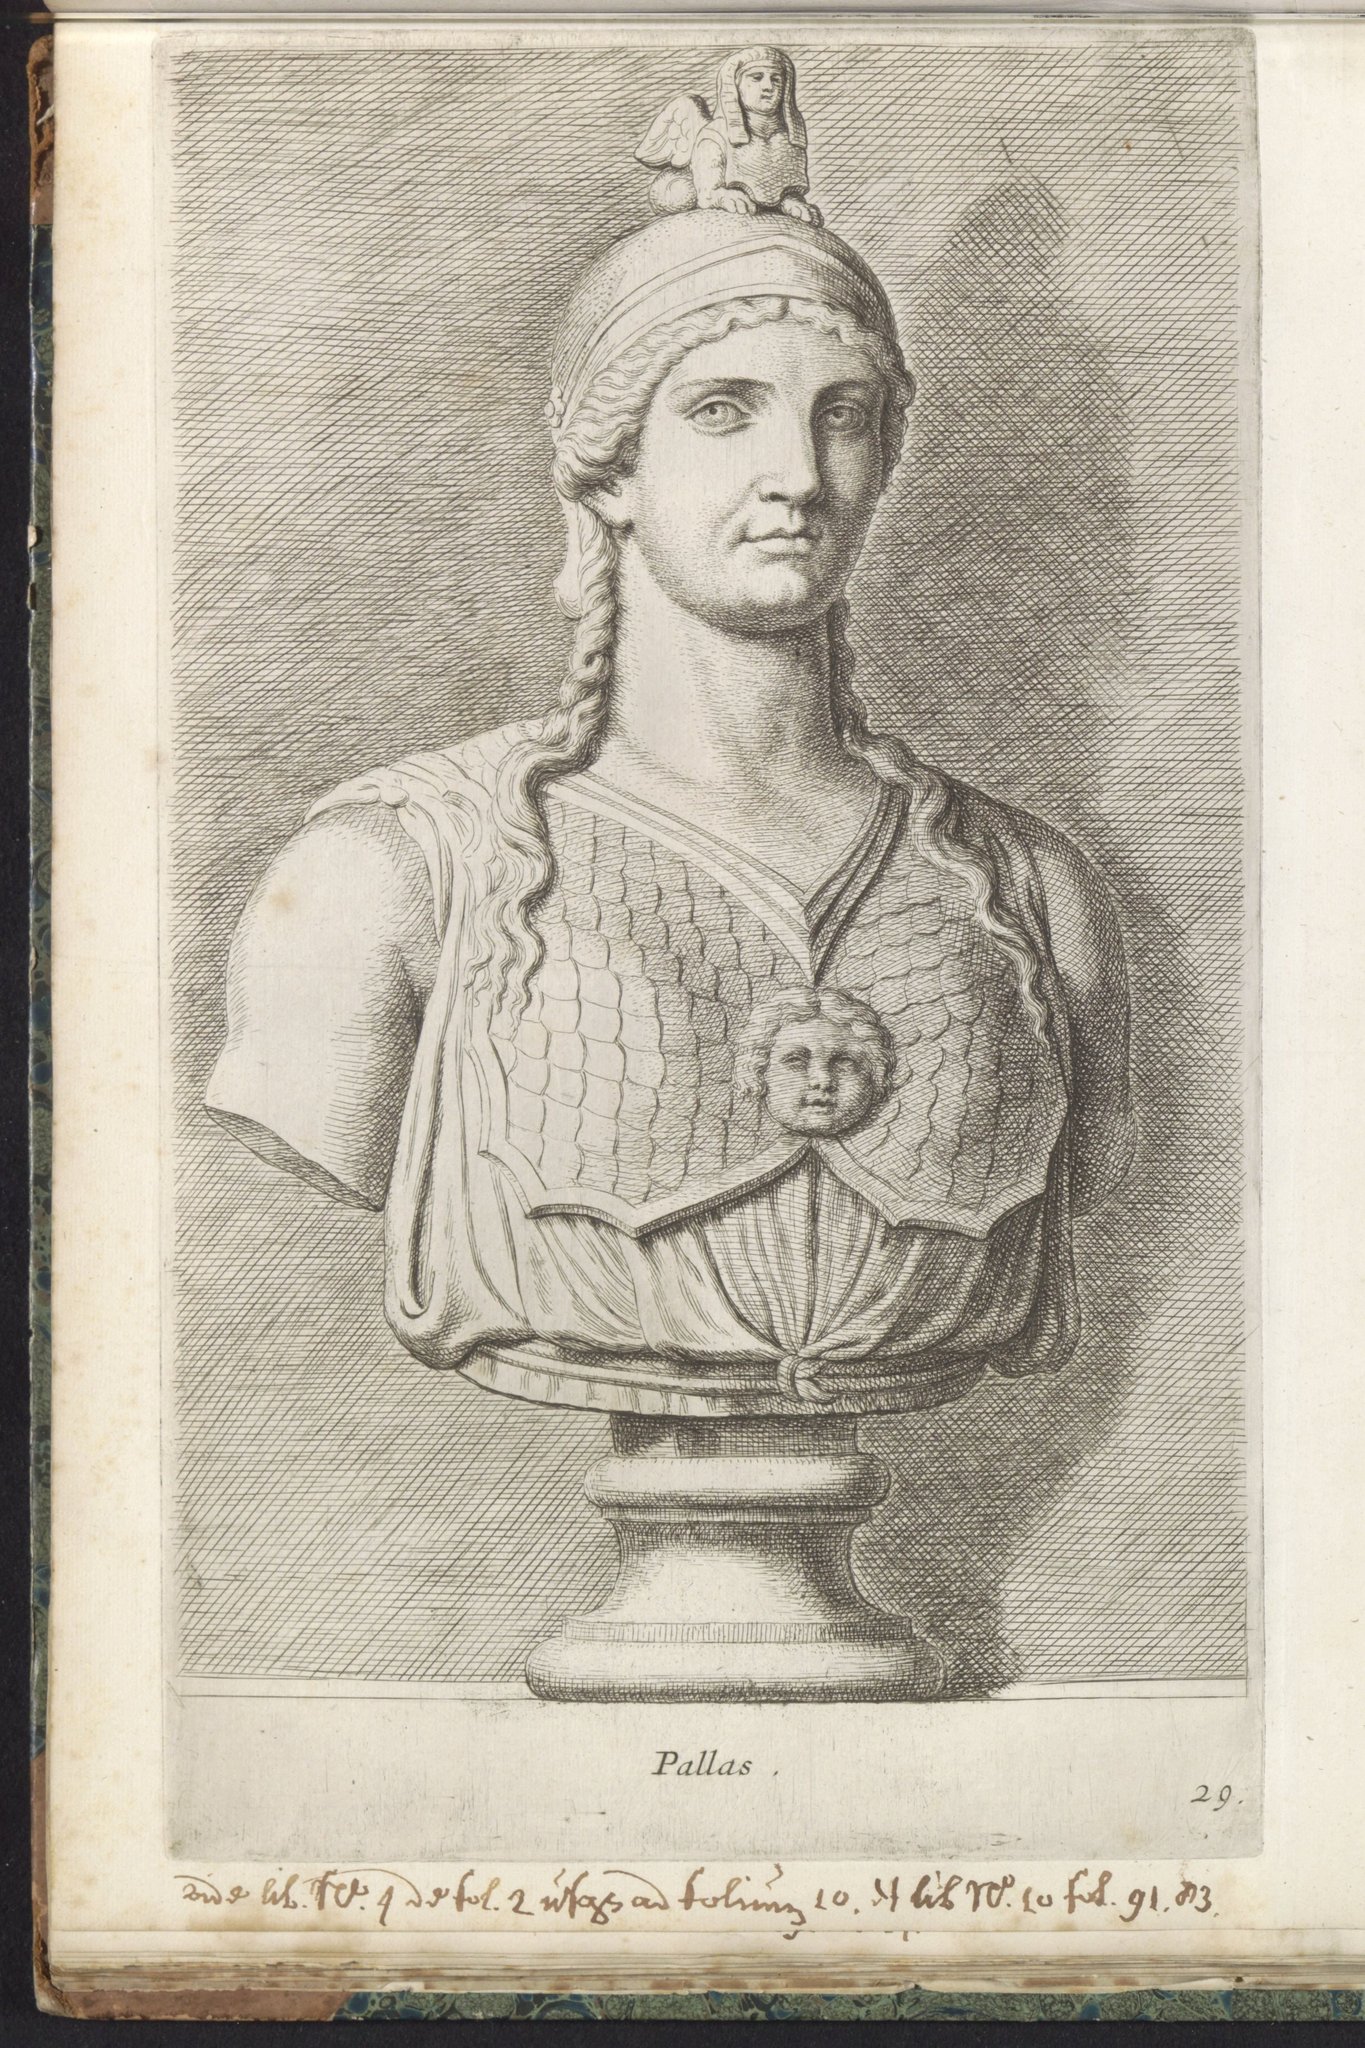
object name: album leaf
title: Buste van Minerva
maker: hubert quellinus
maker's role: print maker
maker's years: 1619-1687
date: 1646-1670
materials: paper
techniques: engraving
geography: antwerp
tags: (story of) minerva (pallas, athena), piece of sculpture, reproduction of a piece of sculpture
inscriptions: inscription: ‘Vide lib. No. 4de fol. 2 ...’, number: ‘54’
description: Klassieke buste van Minerva met op haar helm een sfinx. De prent maakt deel uit van een album met een serie prenten naar de sculpturen in de verzameling van Gerard Reynst.